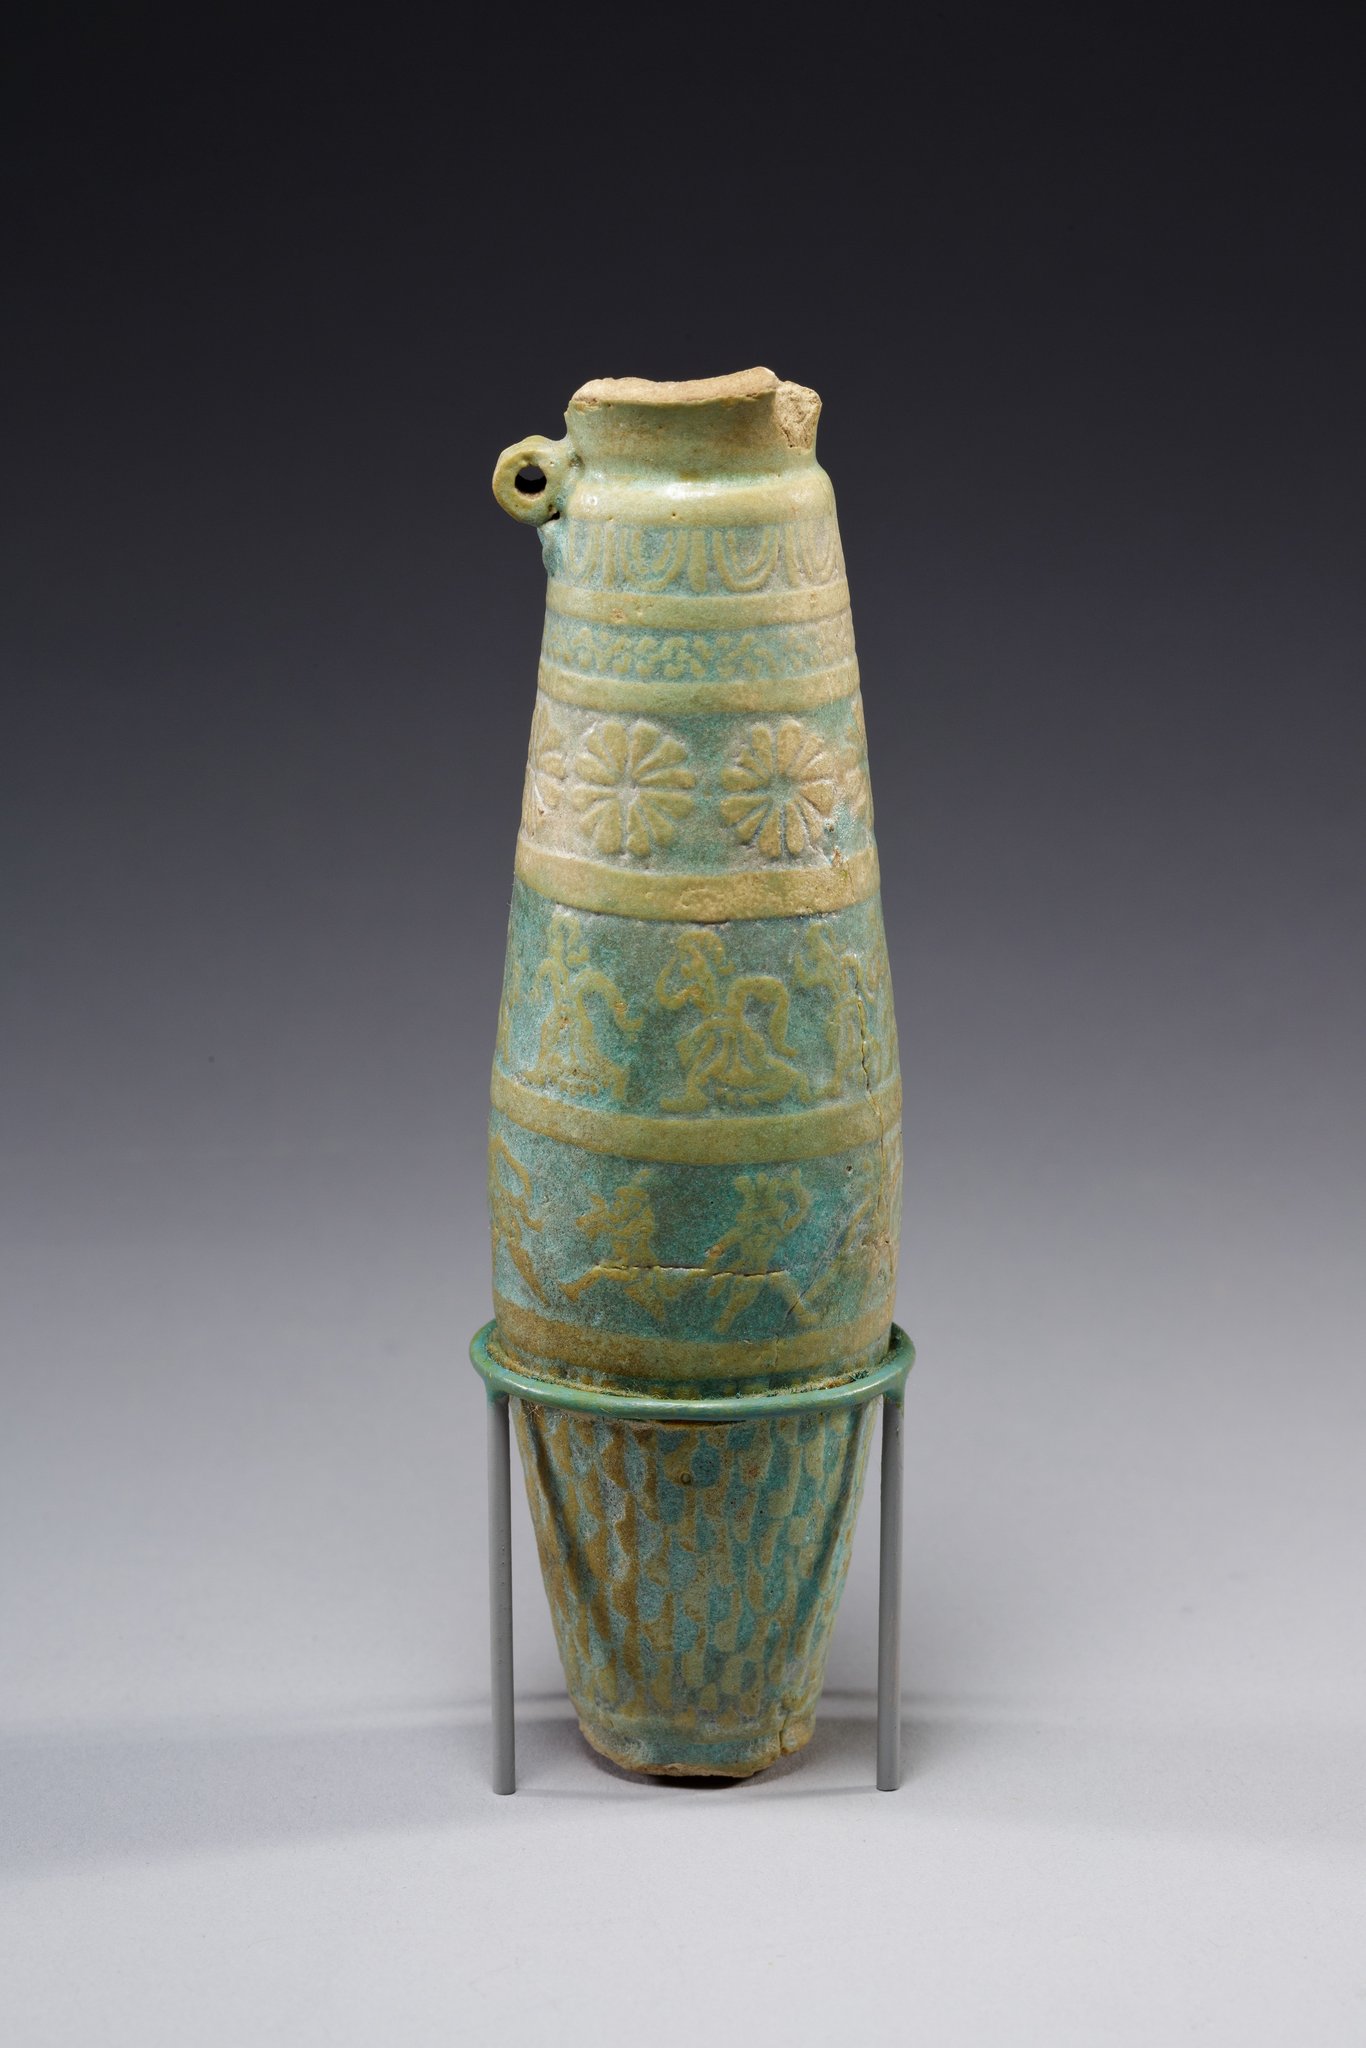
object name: vase, alabastron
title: Biconical alabastron with zones of bichrome decoration including floral elements, dancers, and Bes-like figures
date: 332-330 BCE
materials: faience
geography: western delta